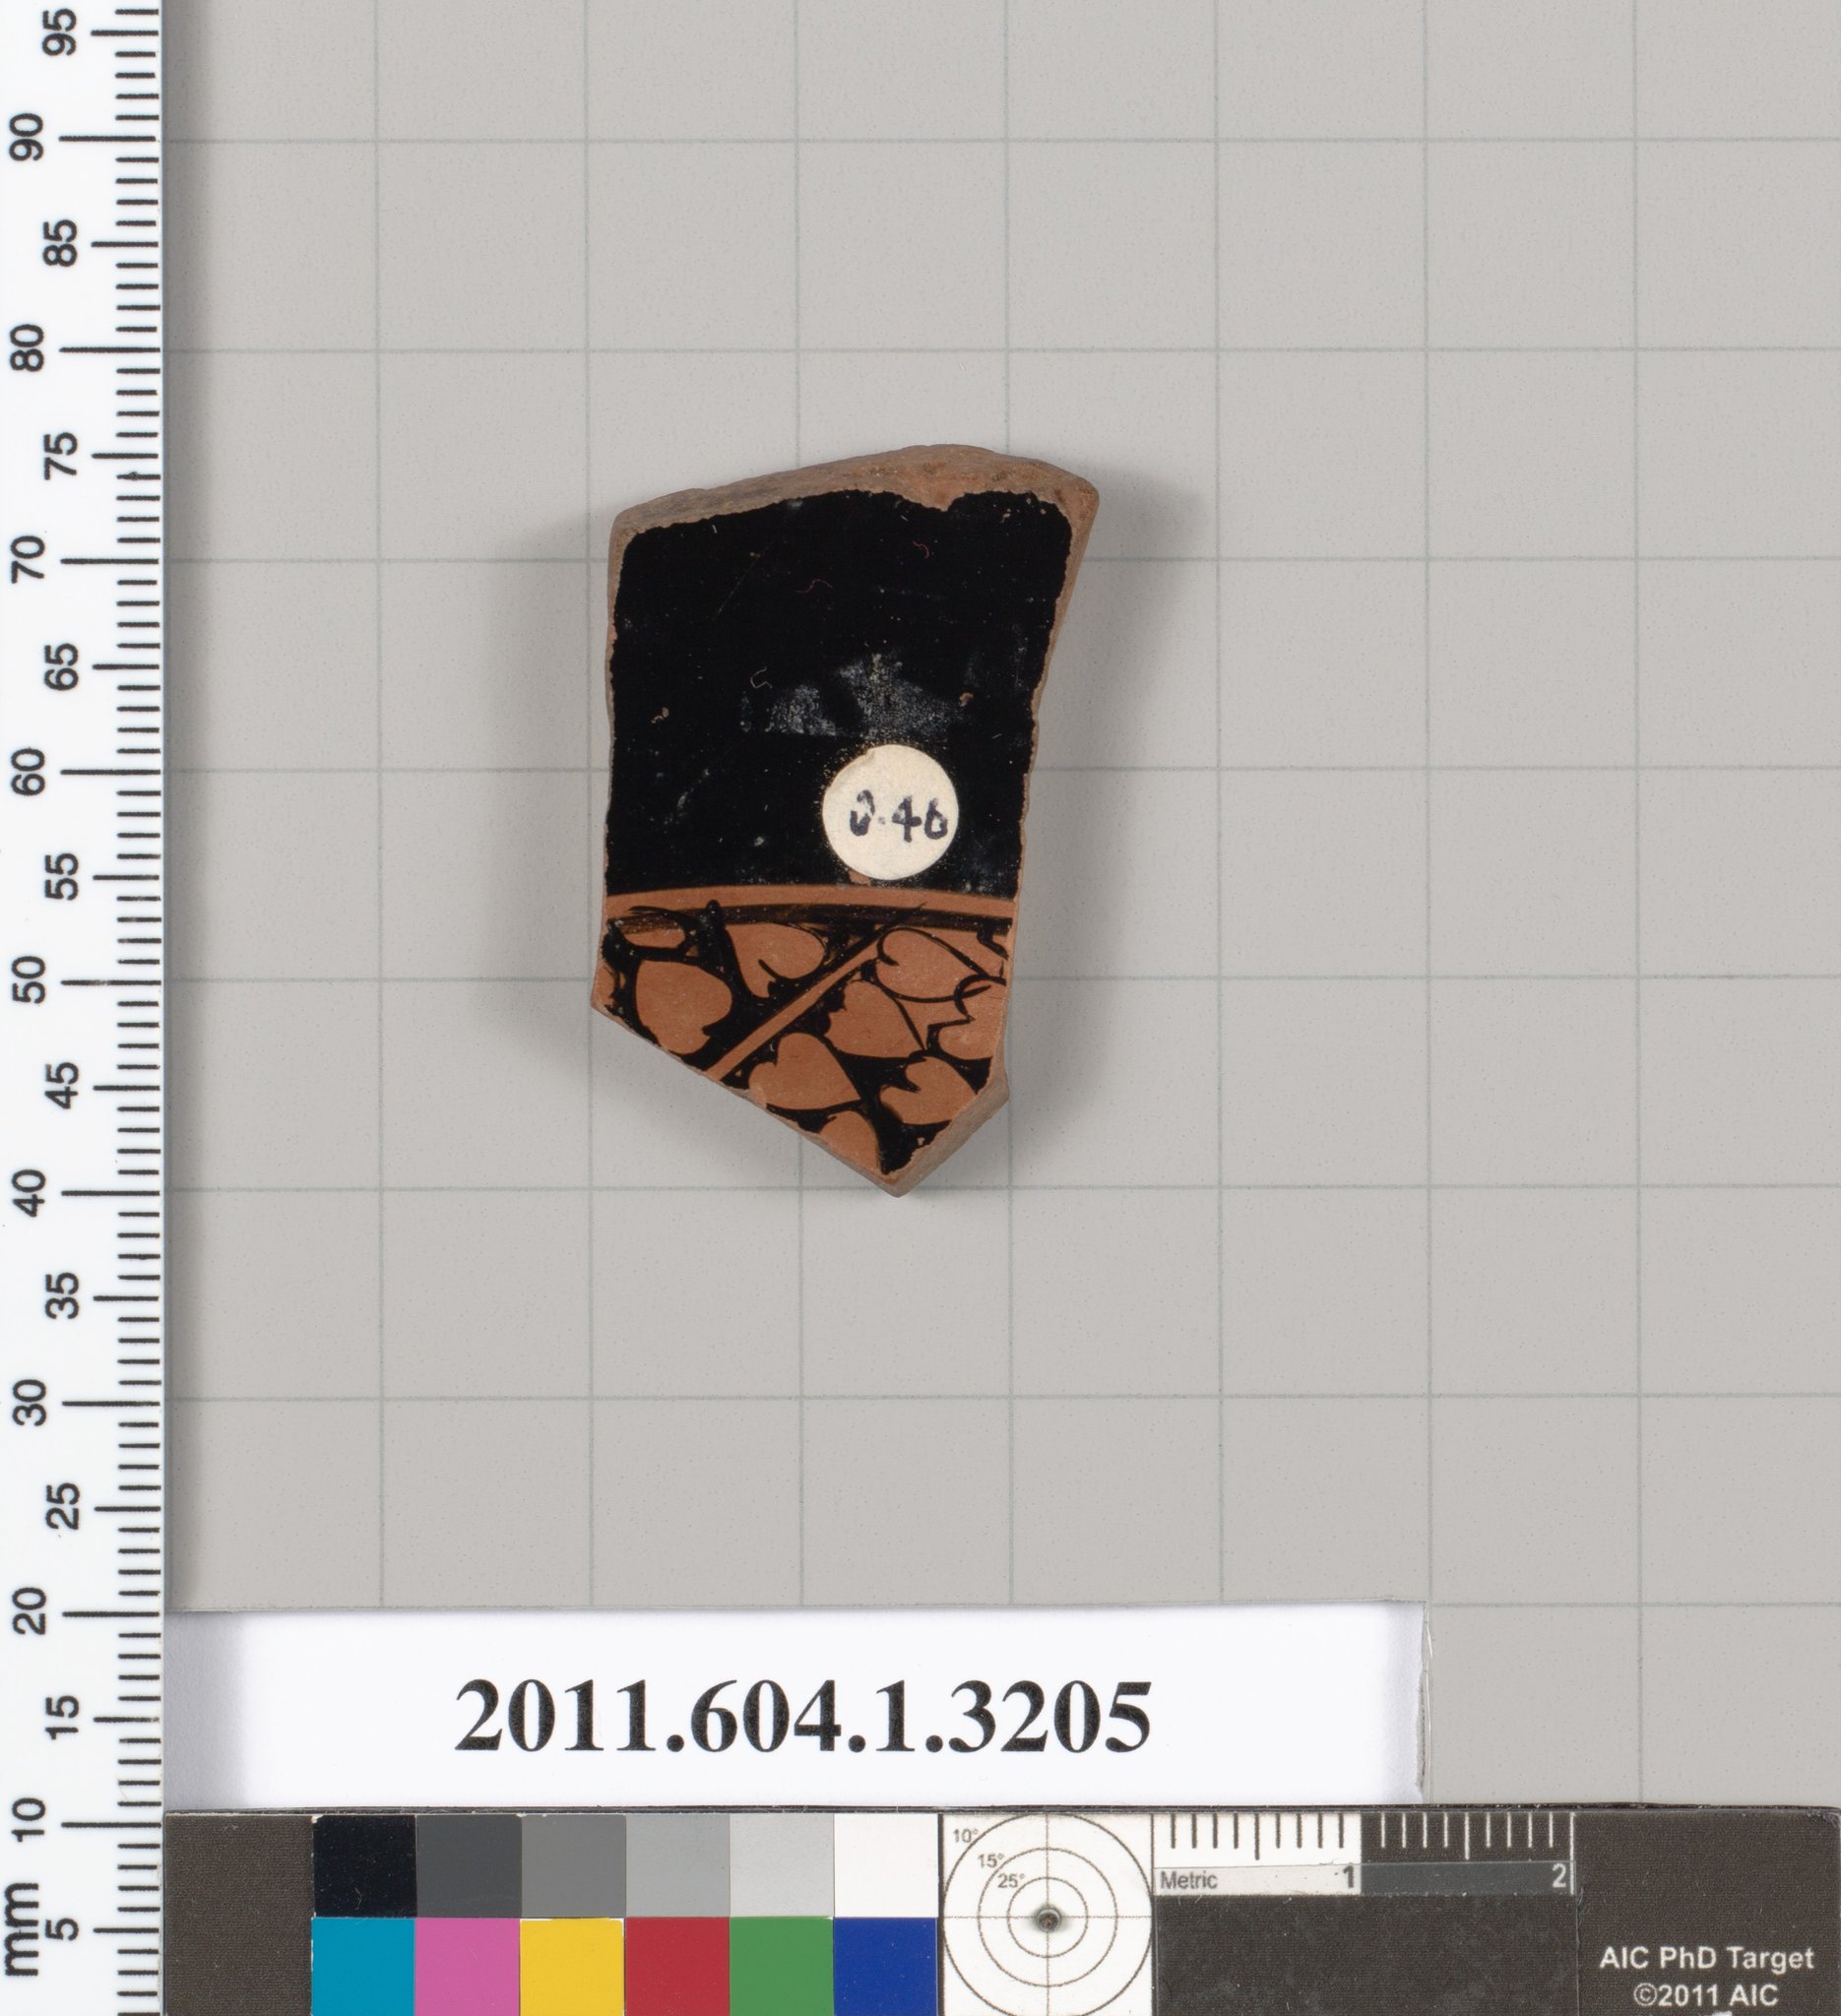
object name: kylix fragment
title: Terracotta fragment of a kylix (drinking cup)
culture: greek, attic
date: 520-500 BCE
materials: terracotta